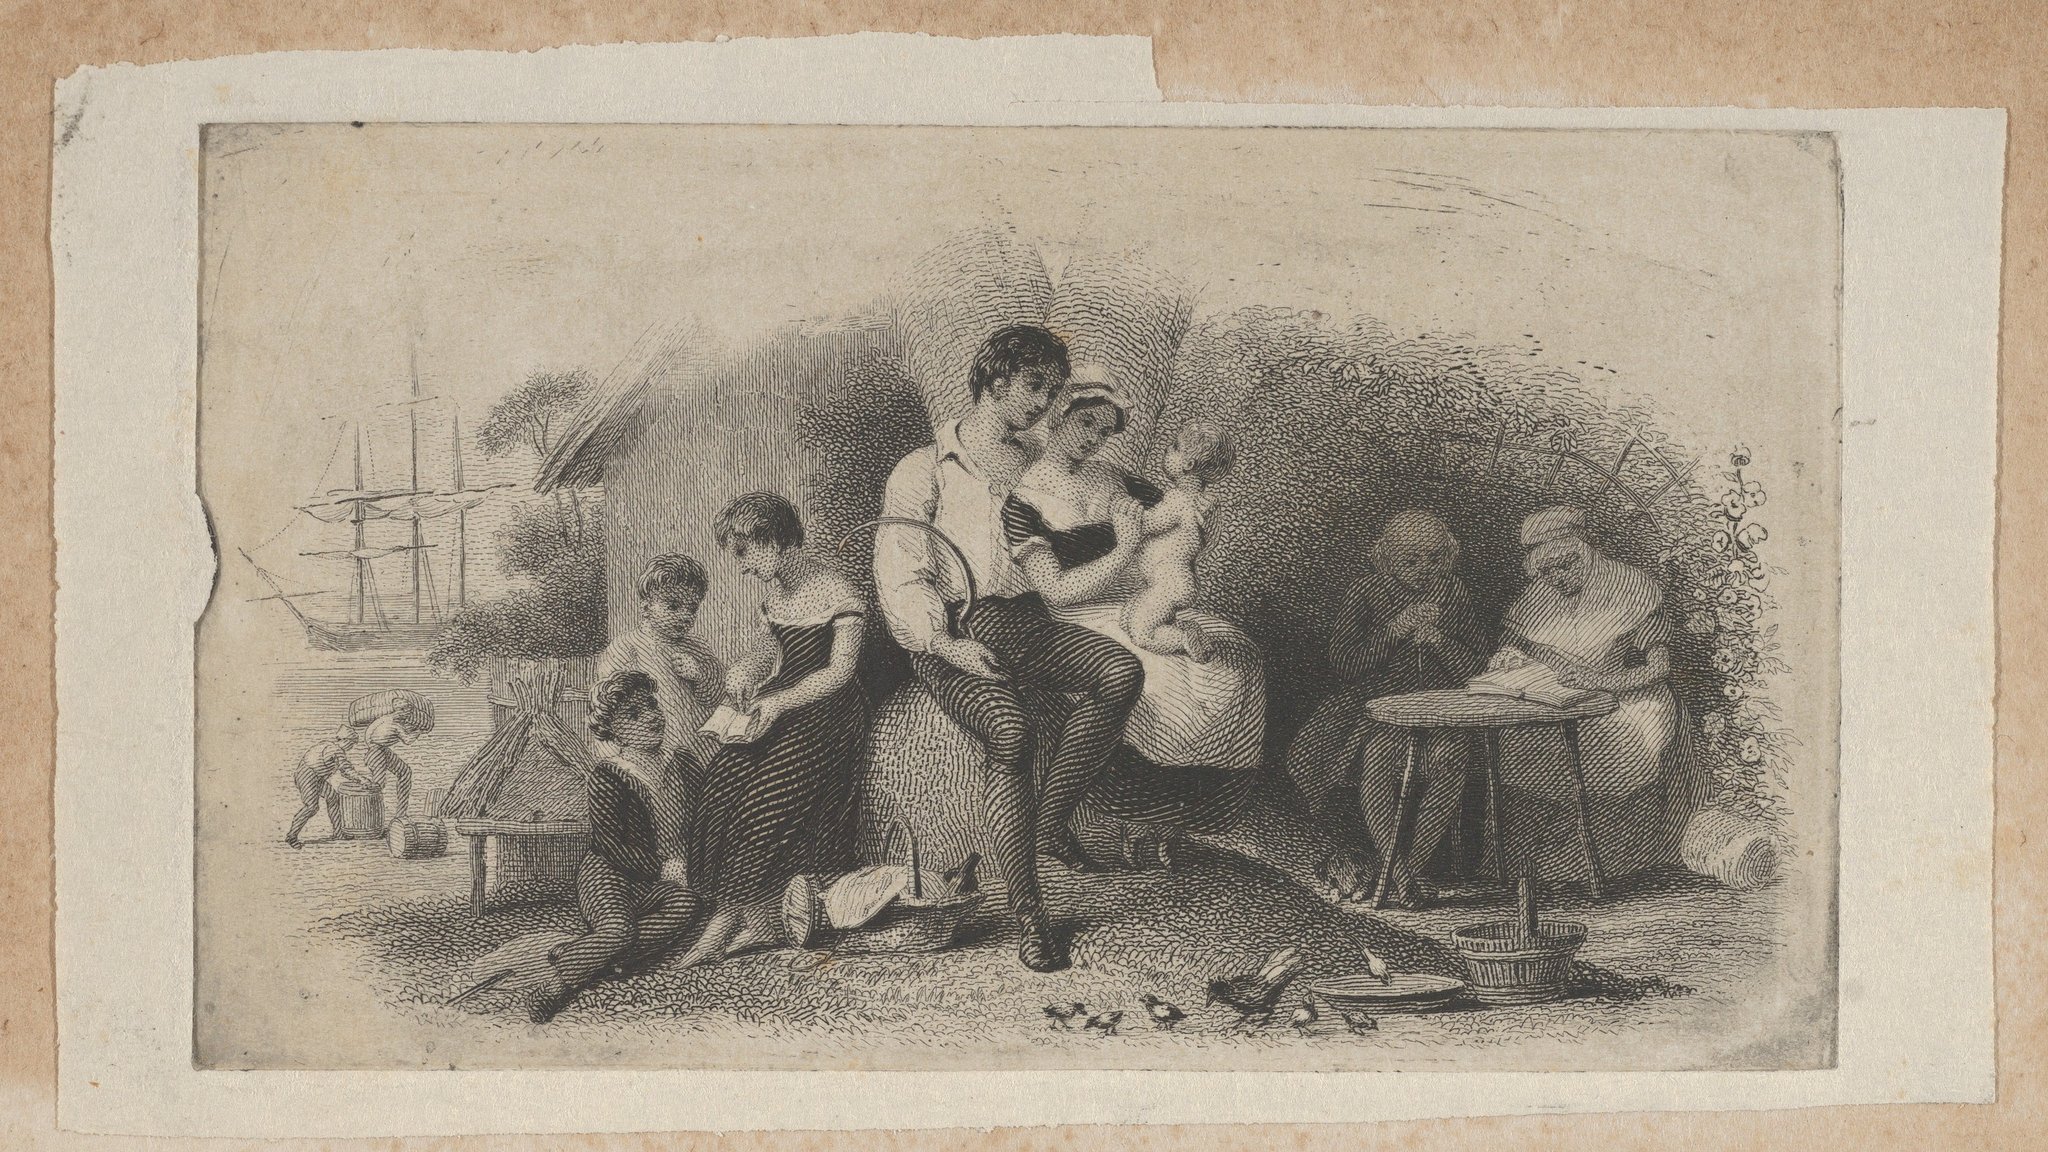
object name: print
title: Banknote vignette with figures of different ages, representing the stages of life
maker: asher brown durand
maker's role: artist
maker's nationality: american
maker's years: 1796-1886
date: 1824-1837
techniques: printmaking, engraving, etching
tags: infants,men,women,money